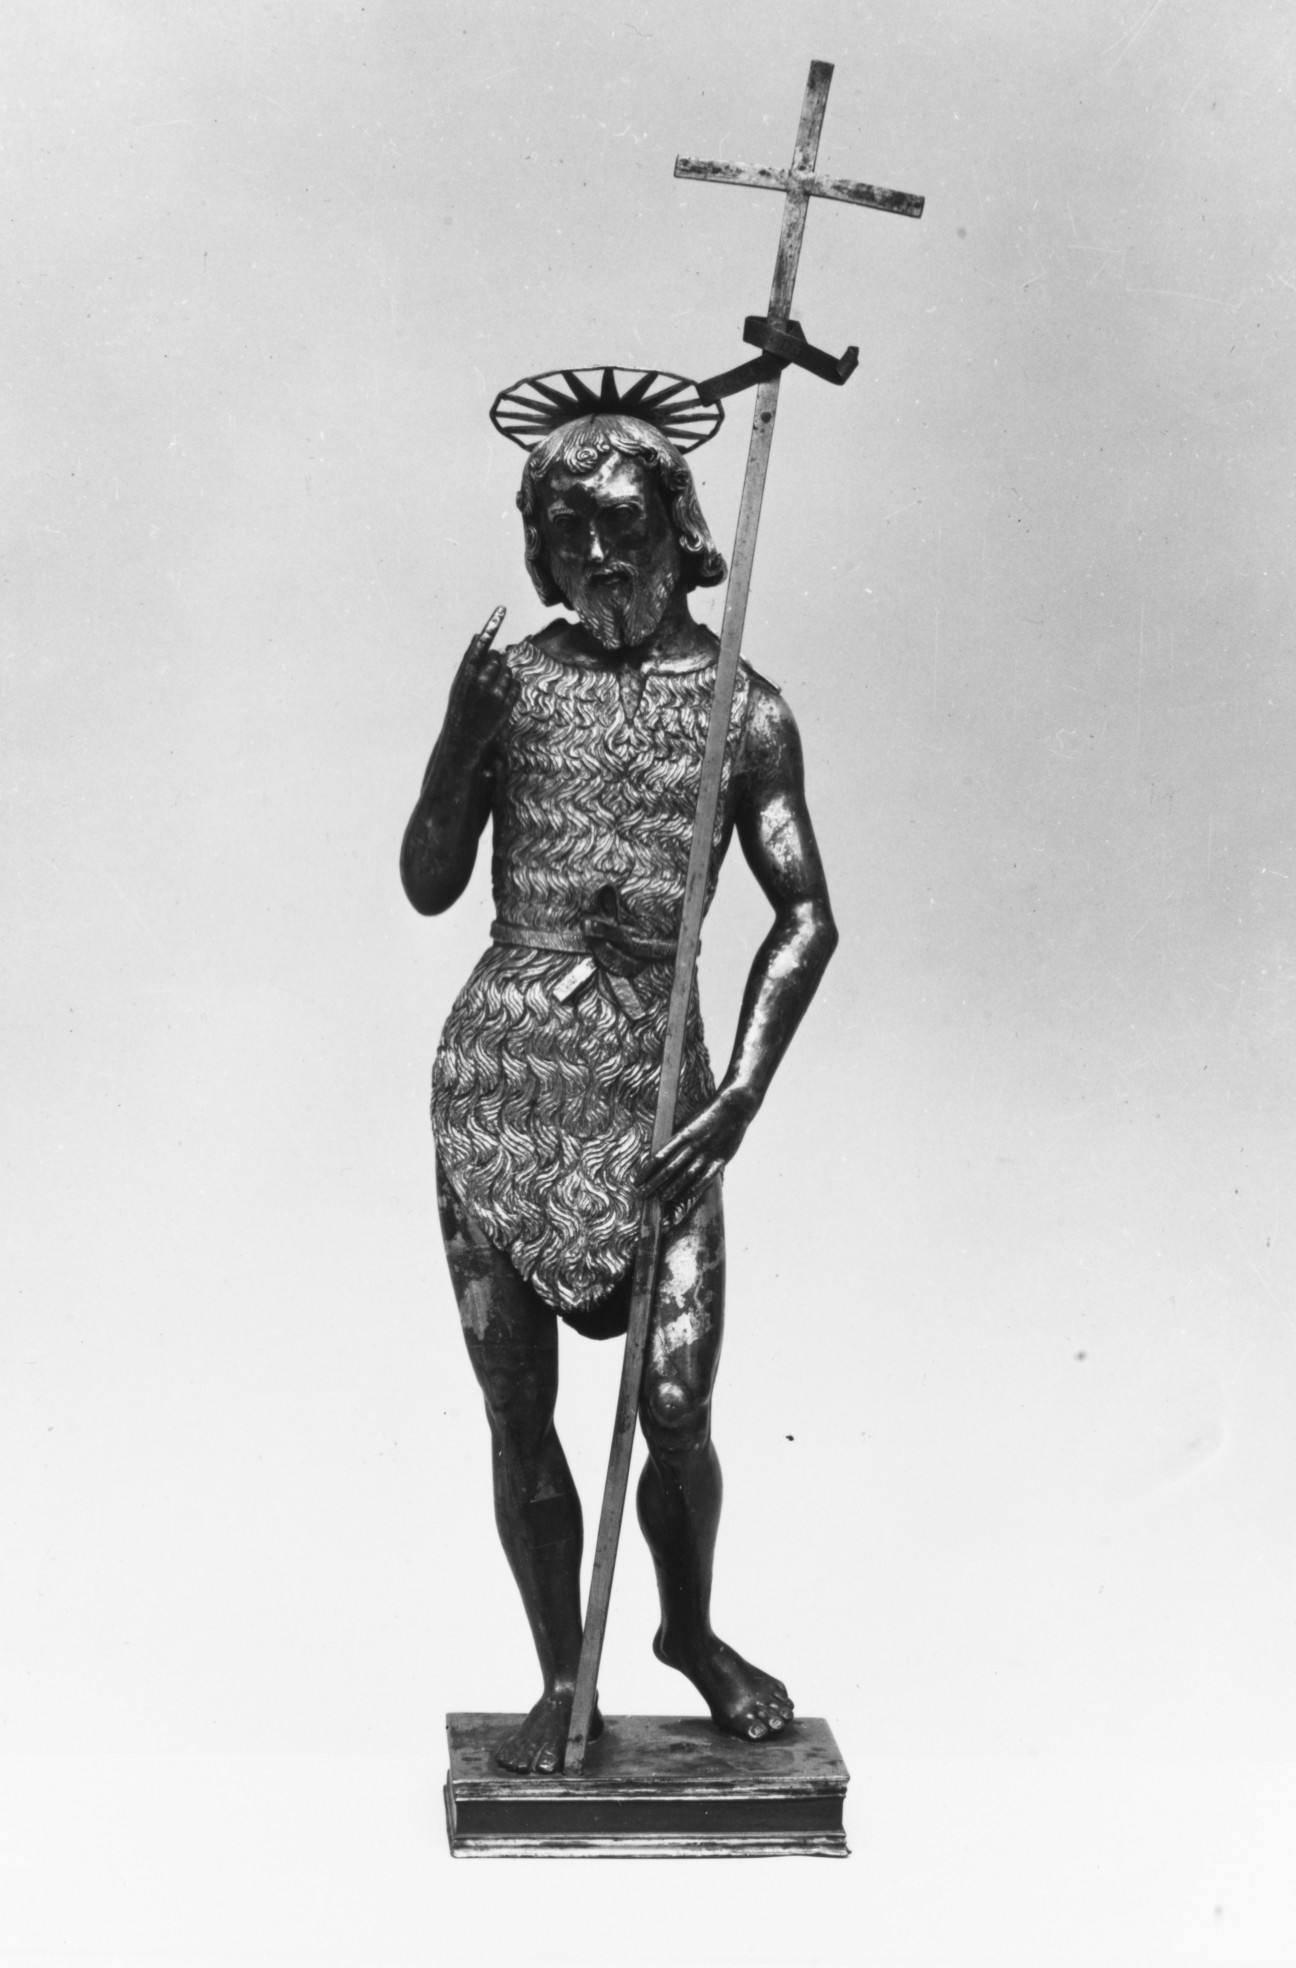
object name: statuette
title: John the Baptist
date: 1467-1500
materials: copper gilt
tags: saint john the baptist,cross